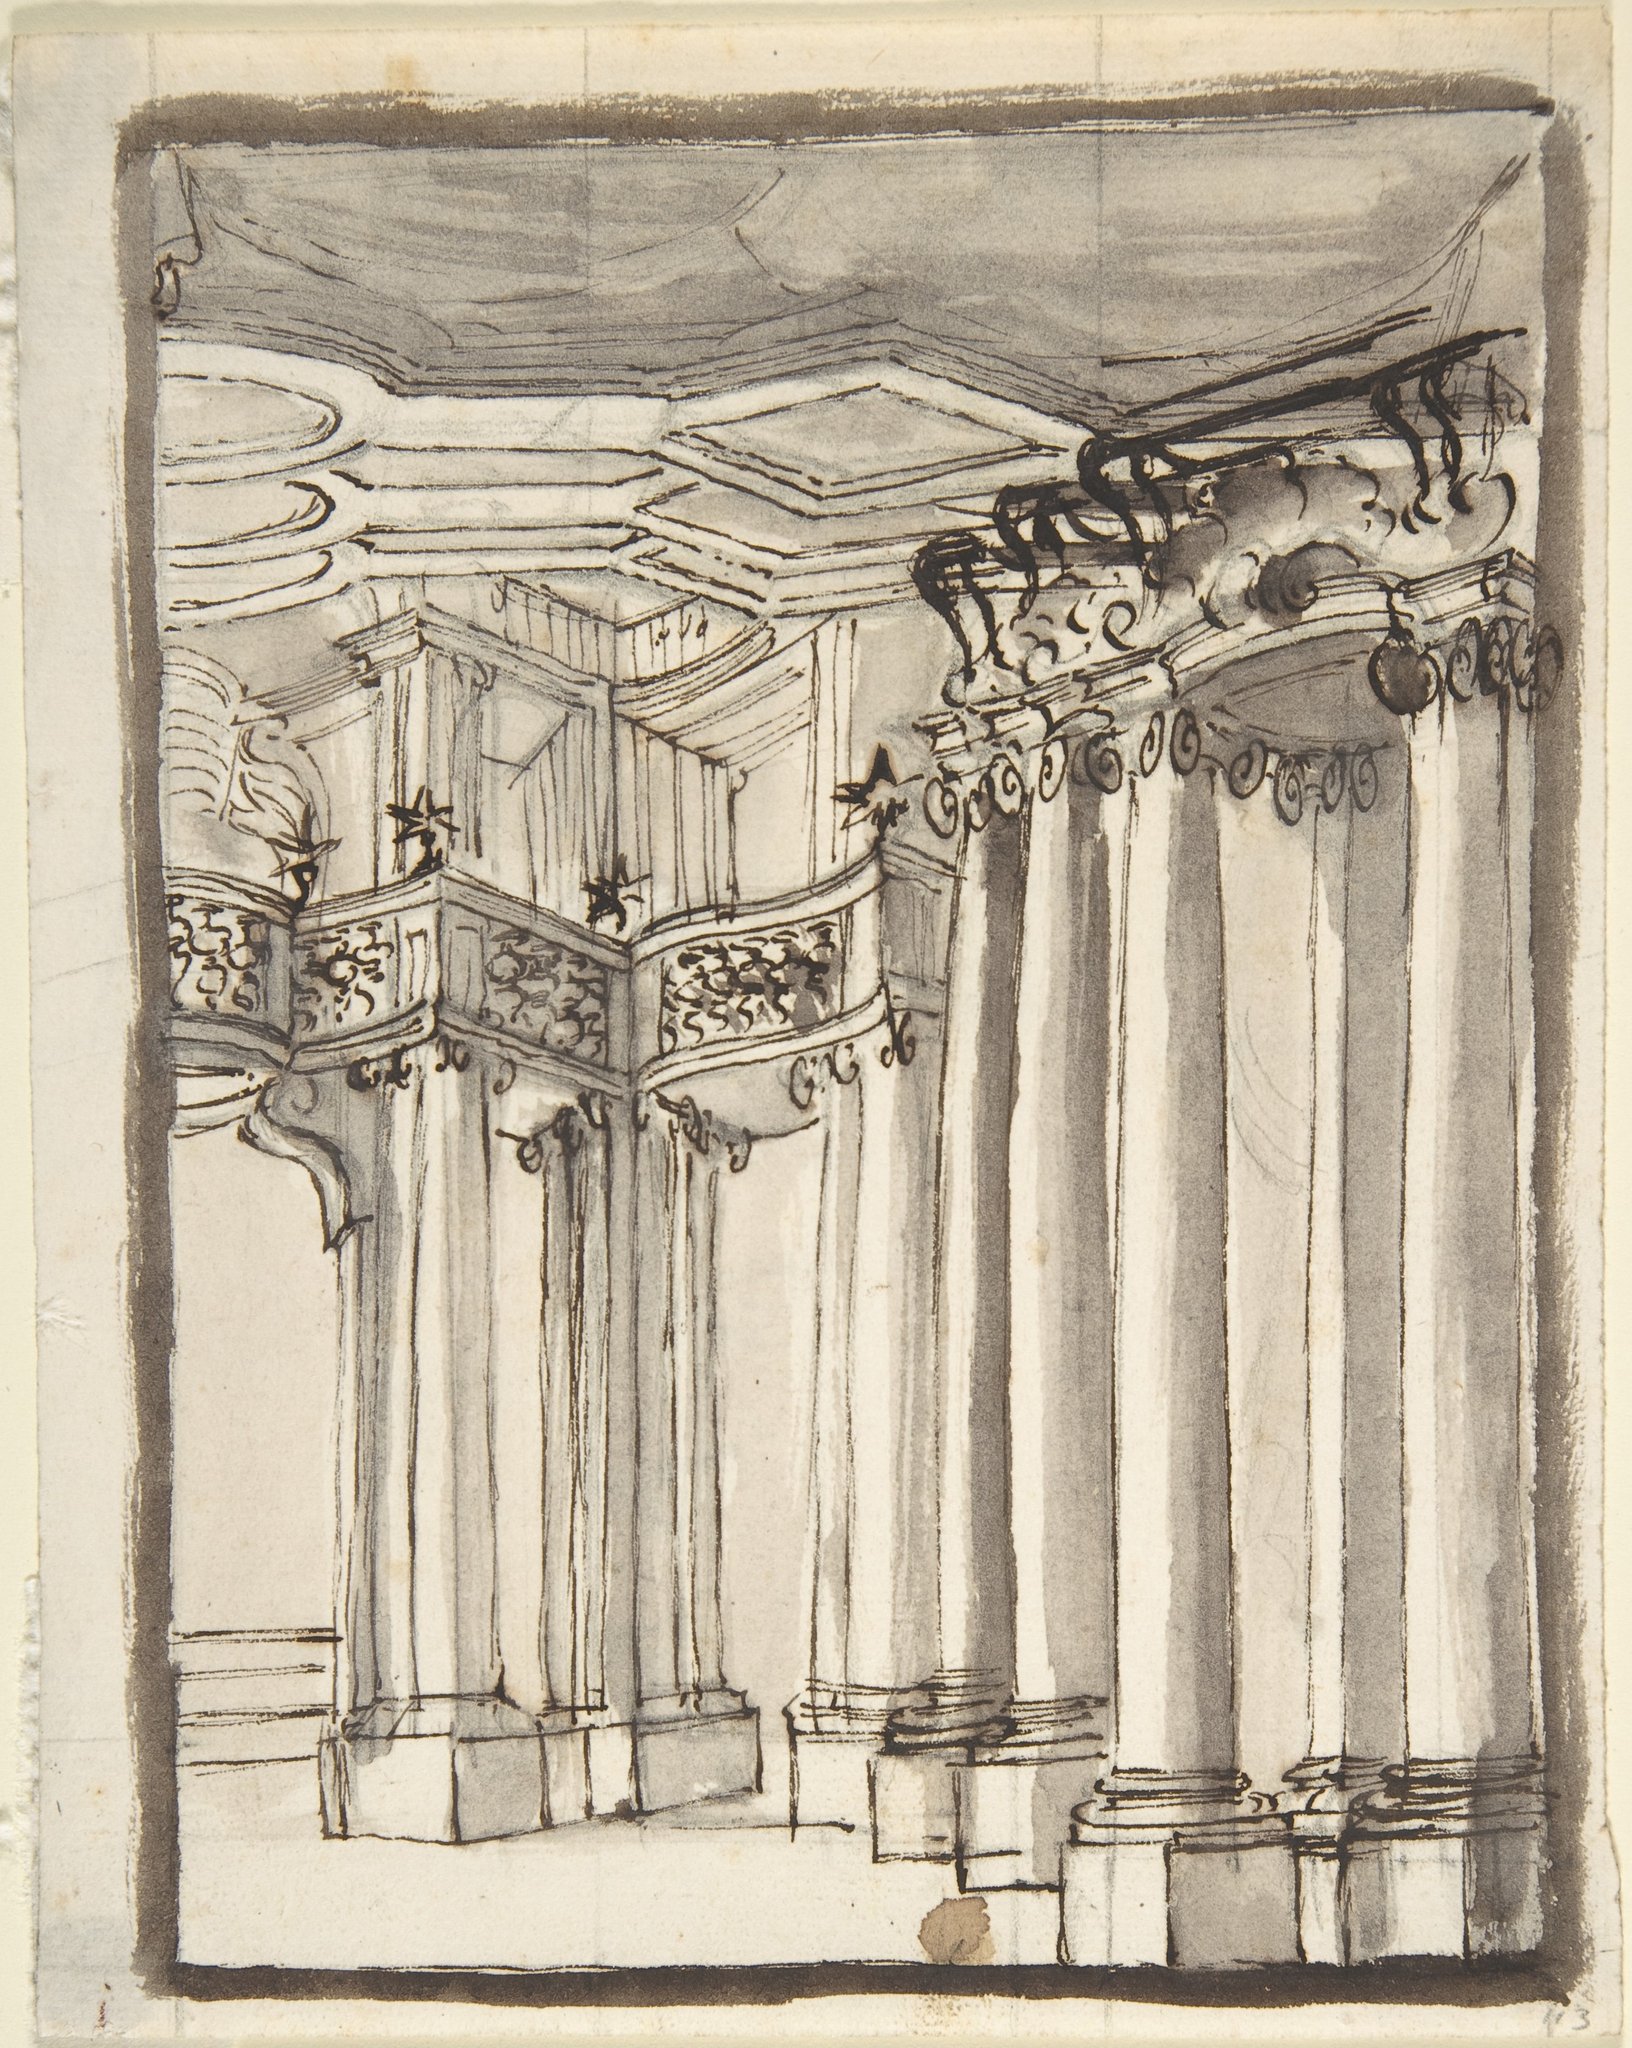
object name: drawing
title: Partial View of an Architectural Interior (recto); Undecipherable Sketches (verso)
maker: anonymous, italian, piedmontese, 18th century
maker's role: artist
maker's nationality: italian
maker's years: 1700-1800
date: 1700-1780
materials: chalk, graphite, ink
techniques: brush, heightening, pen, wash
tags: architecture,columns